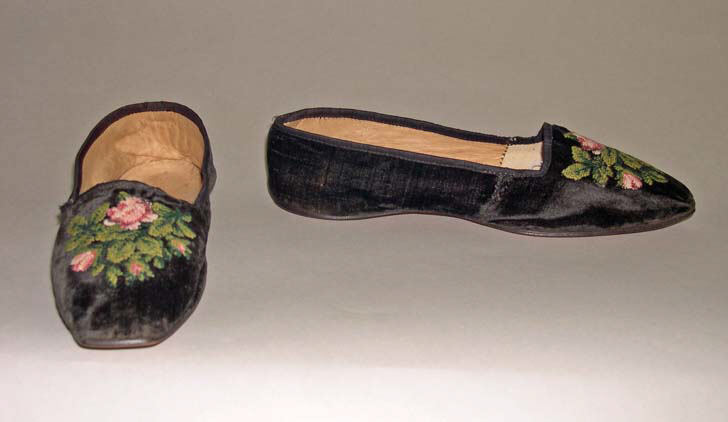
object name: slipper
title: Slippers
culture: american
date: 1844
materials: leather, silk, wool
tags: flowers